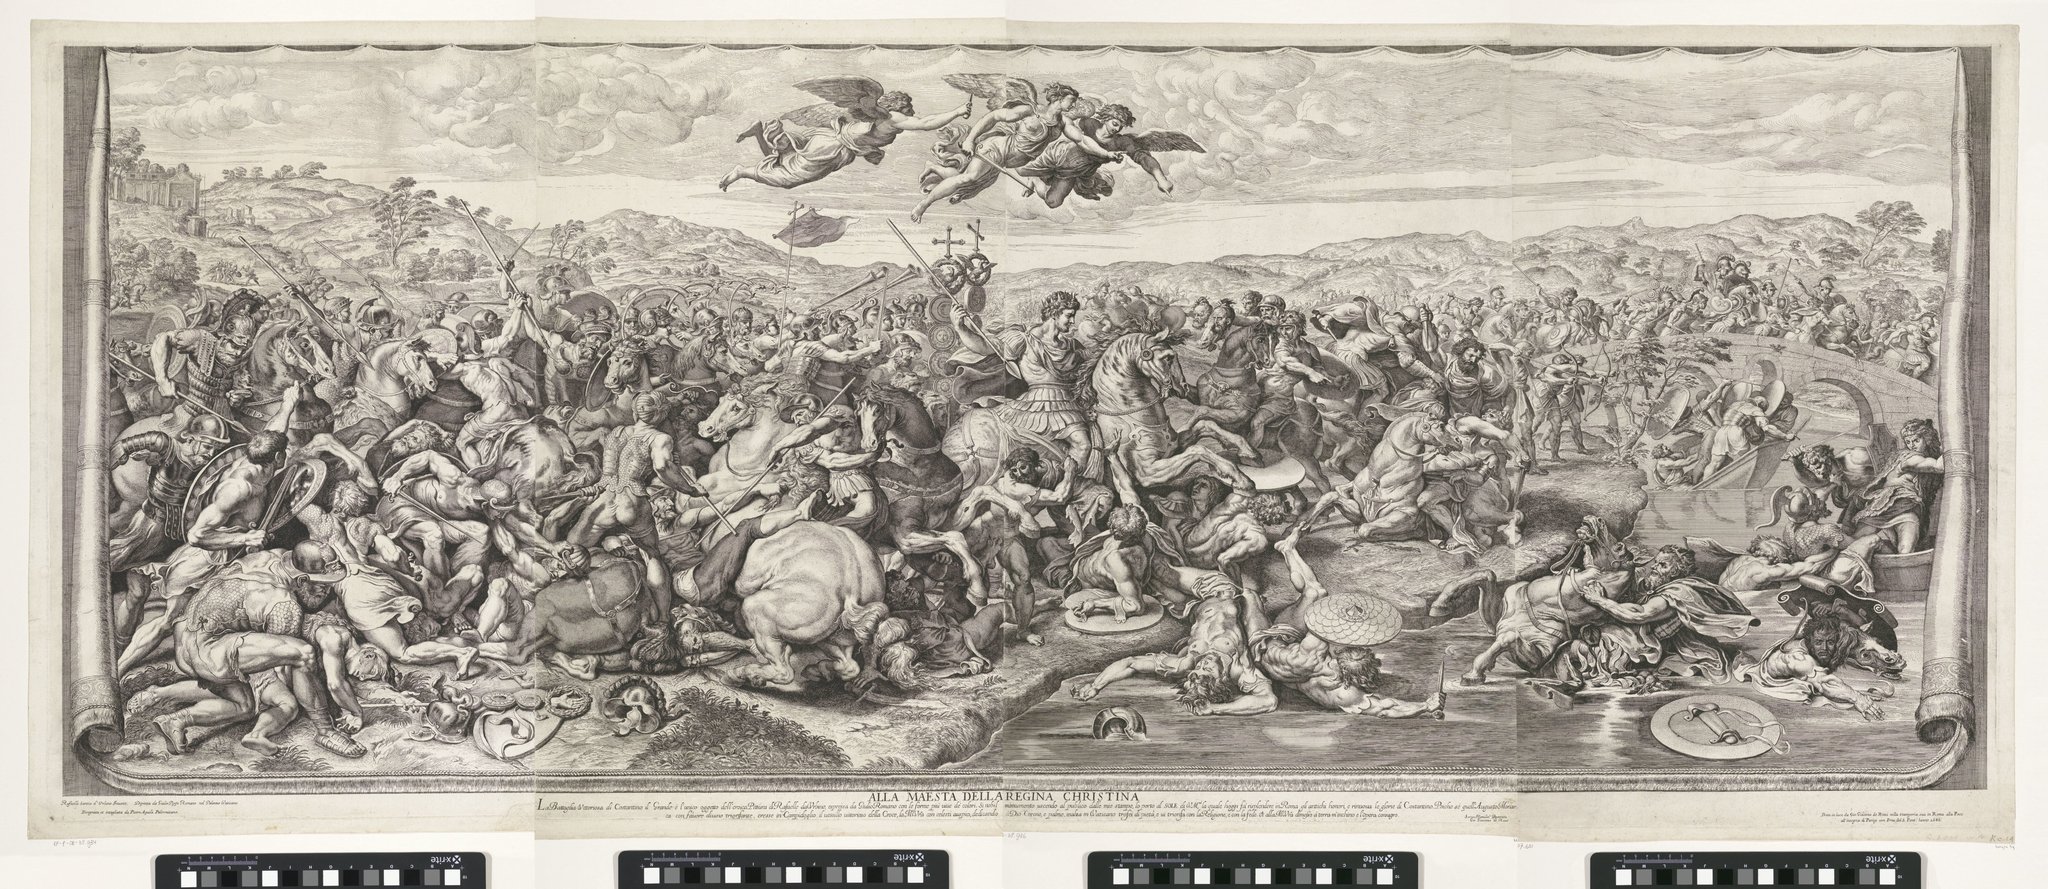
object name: print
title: Slag bij de Milvische brug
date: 1683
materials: paper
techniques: etching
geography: rome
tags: the battle of the milvian bridge (saxa rubra): st. constantine on horseback confronts maxentius; a cross appears in the sky with in fiery letters 'in hoc signo vinces' (the raised standards of the roman soldiers carry a cross or the chi-rho monogram), warfare; military affairs (+ cavalry, horsemen), the soldier; the soldier's life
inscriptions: collector's mark: Lugt 240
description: Gevechtsscène in een landschap: slag bij de Milvische brug. De soldaten van Constantijn in gevecht met de soldaten van Maxentius. Dode lichamen liggen op de grond. Soldaten te paard verdrinken in de rivier.